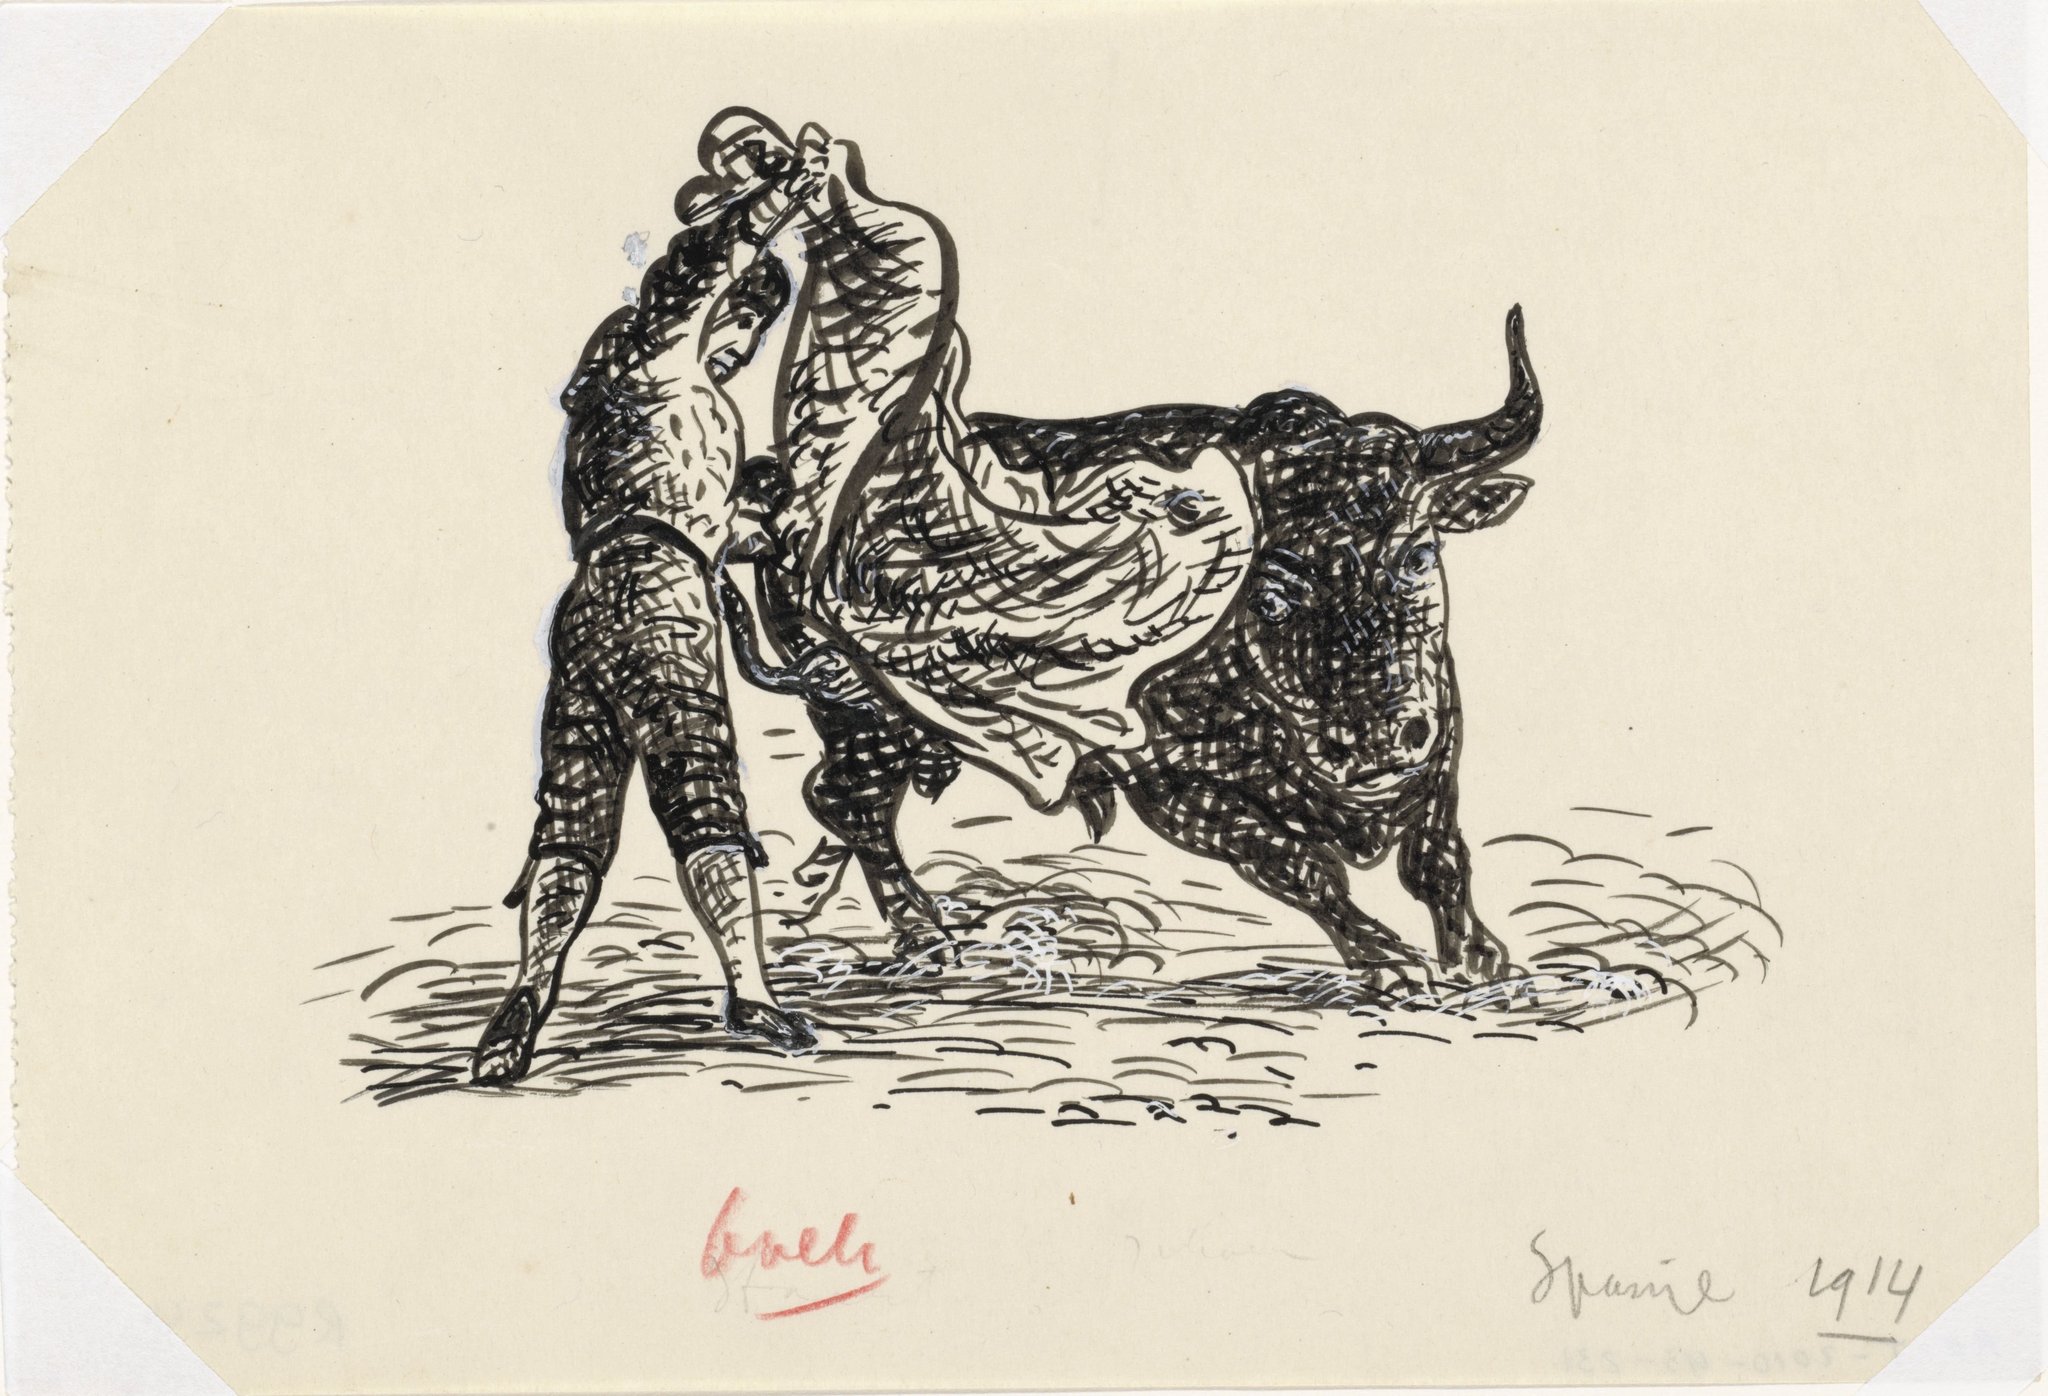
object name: drawing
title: Zonder titel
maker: leo gestel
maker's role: draughtsman, print maker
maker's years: 1881-1941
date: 1935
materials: gouache, ink, paper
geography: spain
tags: bullfight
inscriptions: inscription: ‘Spanje 1914’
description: Stierenvechter met opgeheven muleta (rode lap), waar ondervandaan rechts van hem een stier frontaal te voorschijn komt.